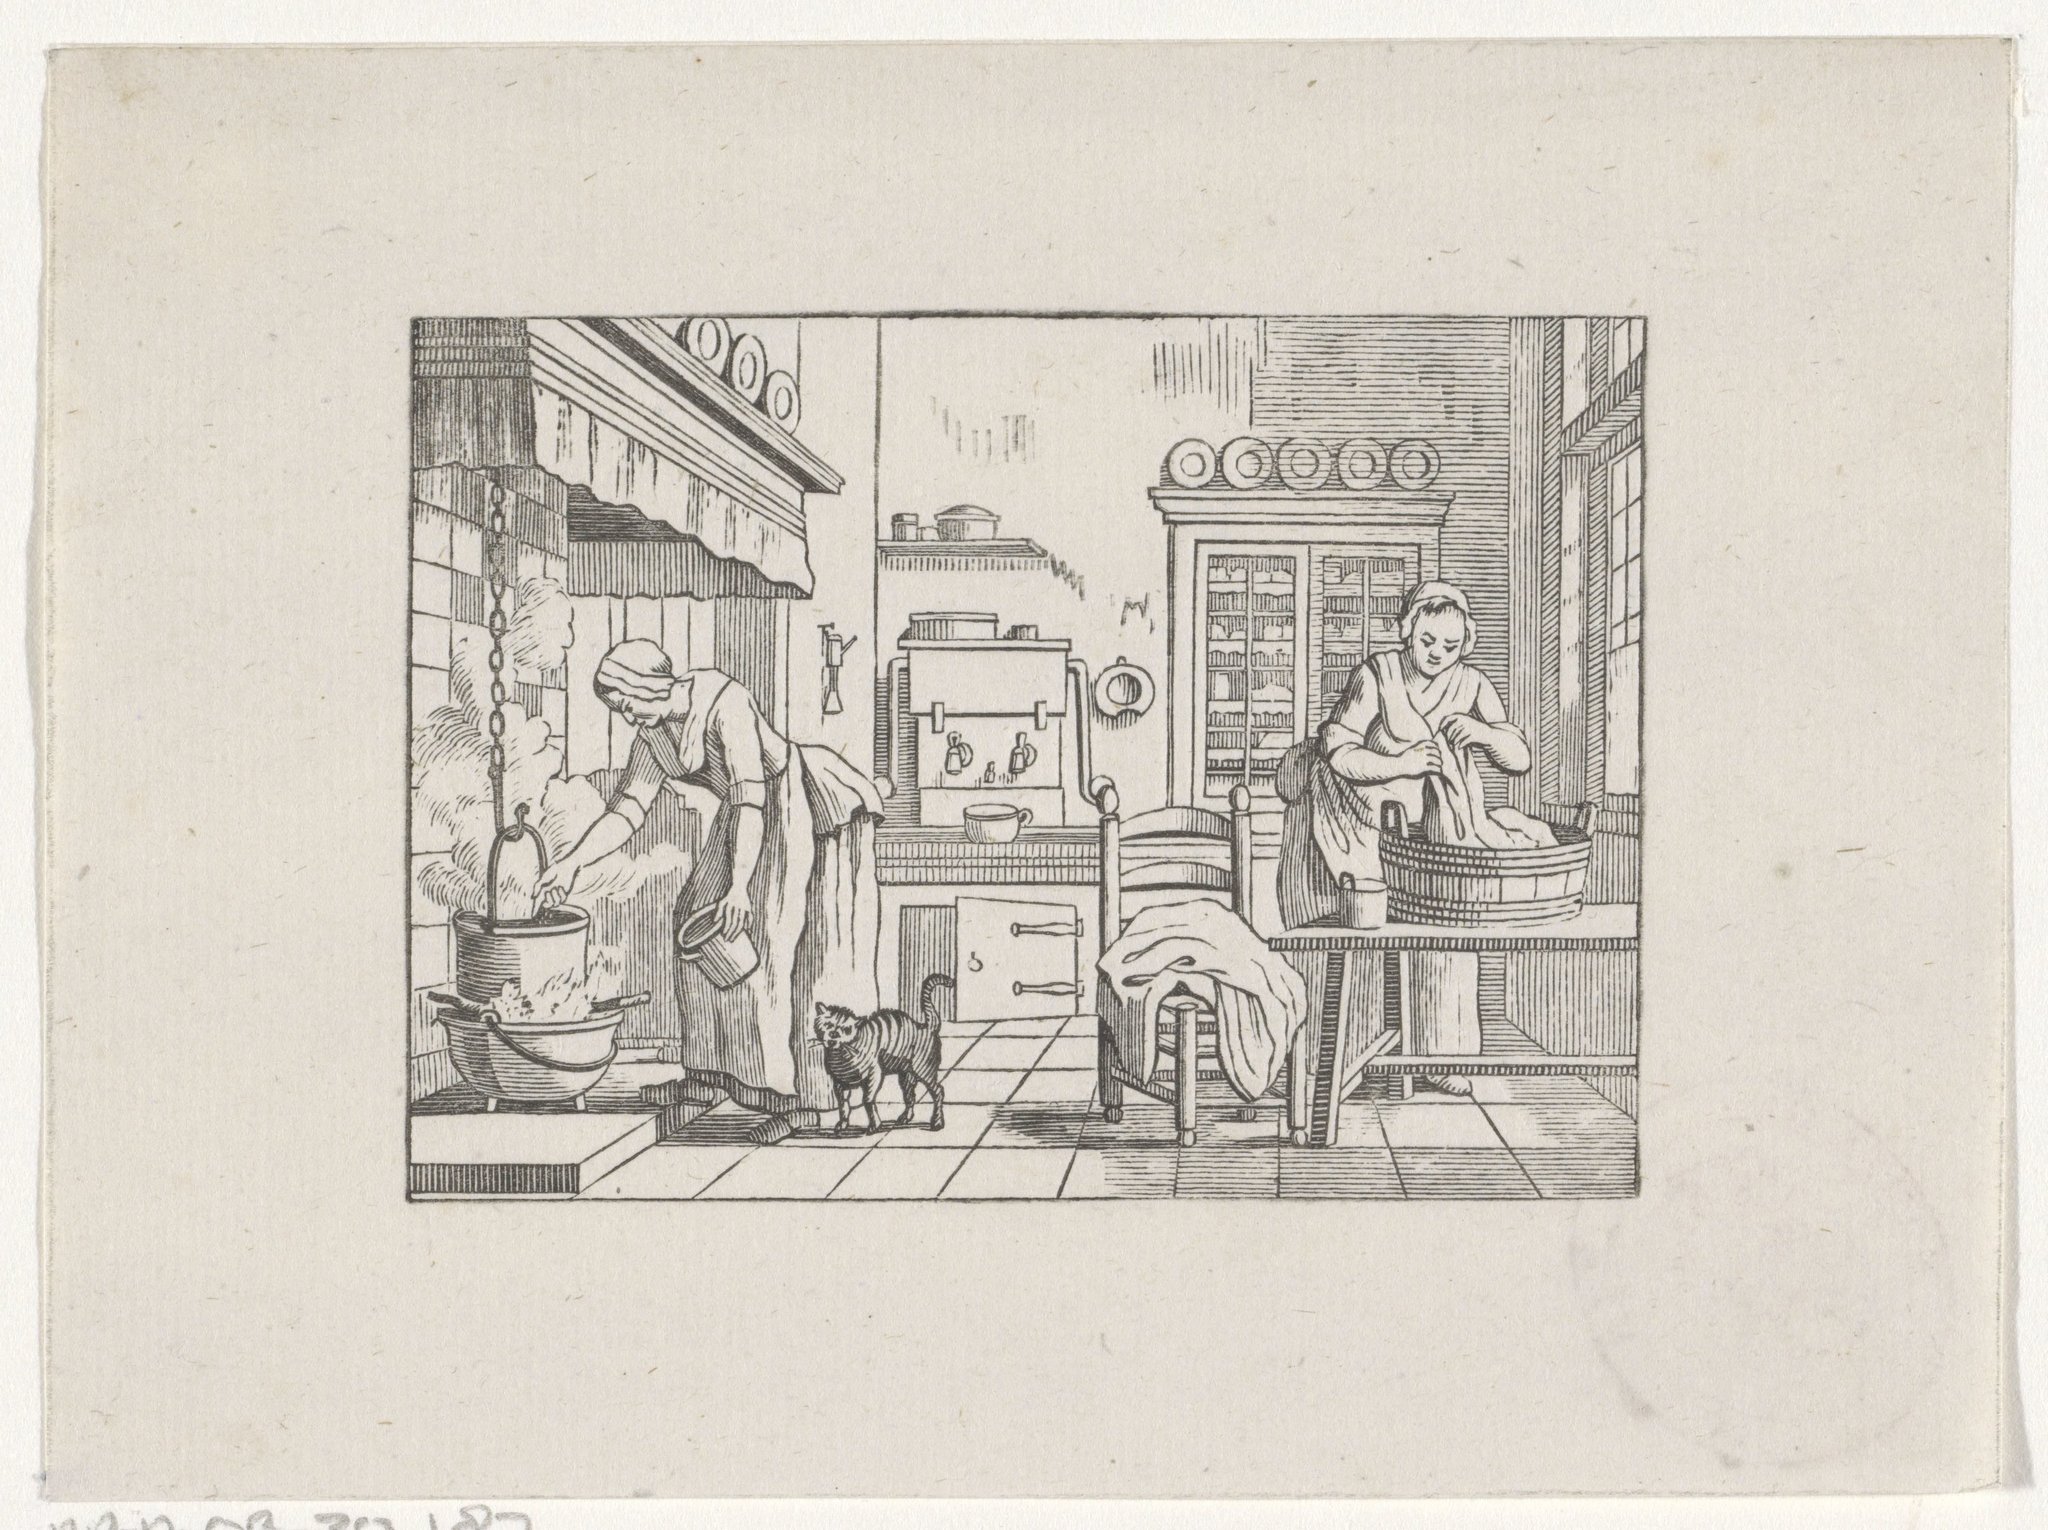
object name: print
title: Keukeninterieur met twee vrouwen aan het werk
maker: hendrik numan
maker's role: draughtsman, print maker, publisher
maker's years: 1736-1788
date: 1746-1788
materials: paper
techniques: woodcut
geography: haarlem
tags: kitchen-interior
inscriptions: collector's mark: Lugt 240